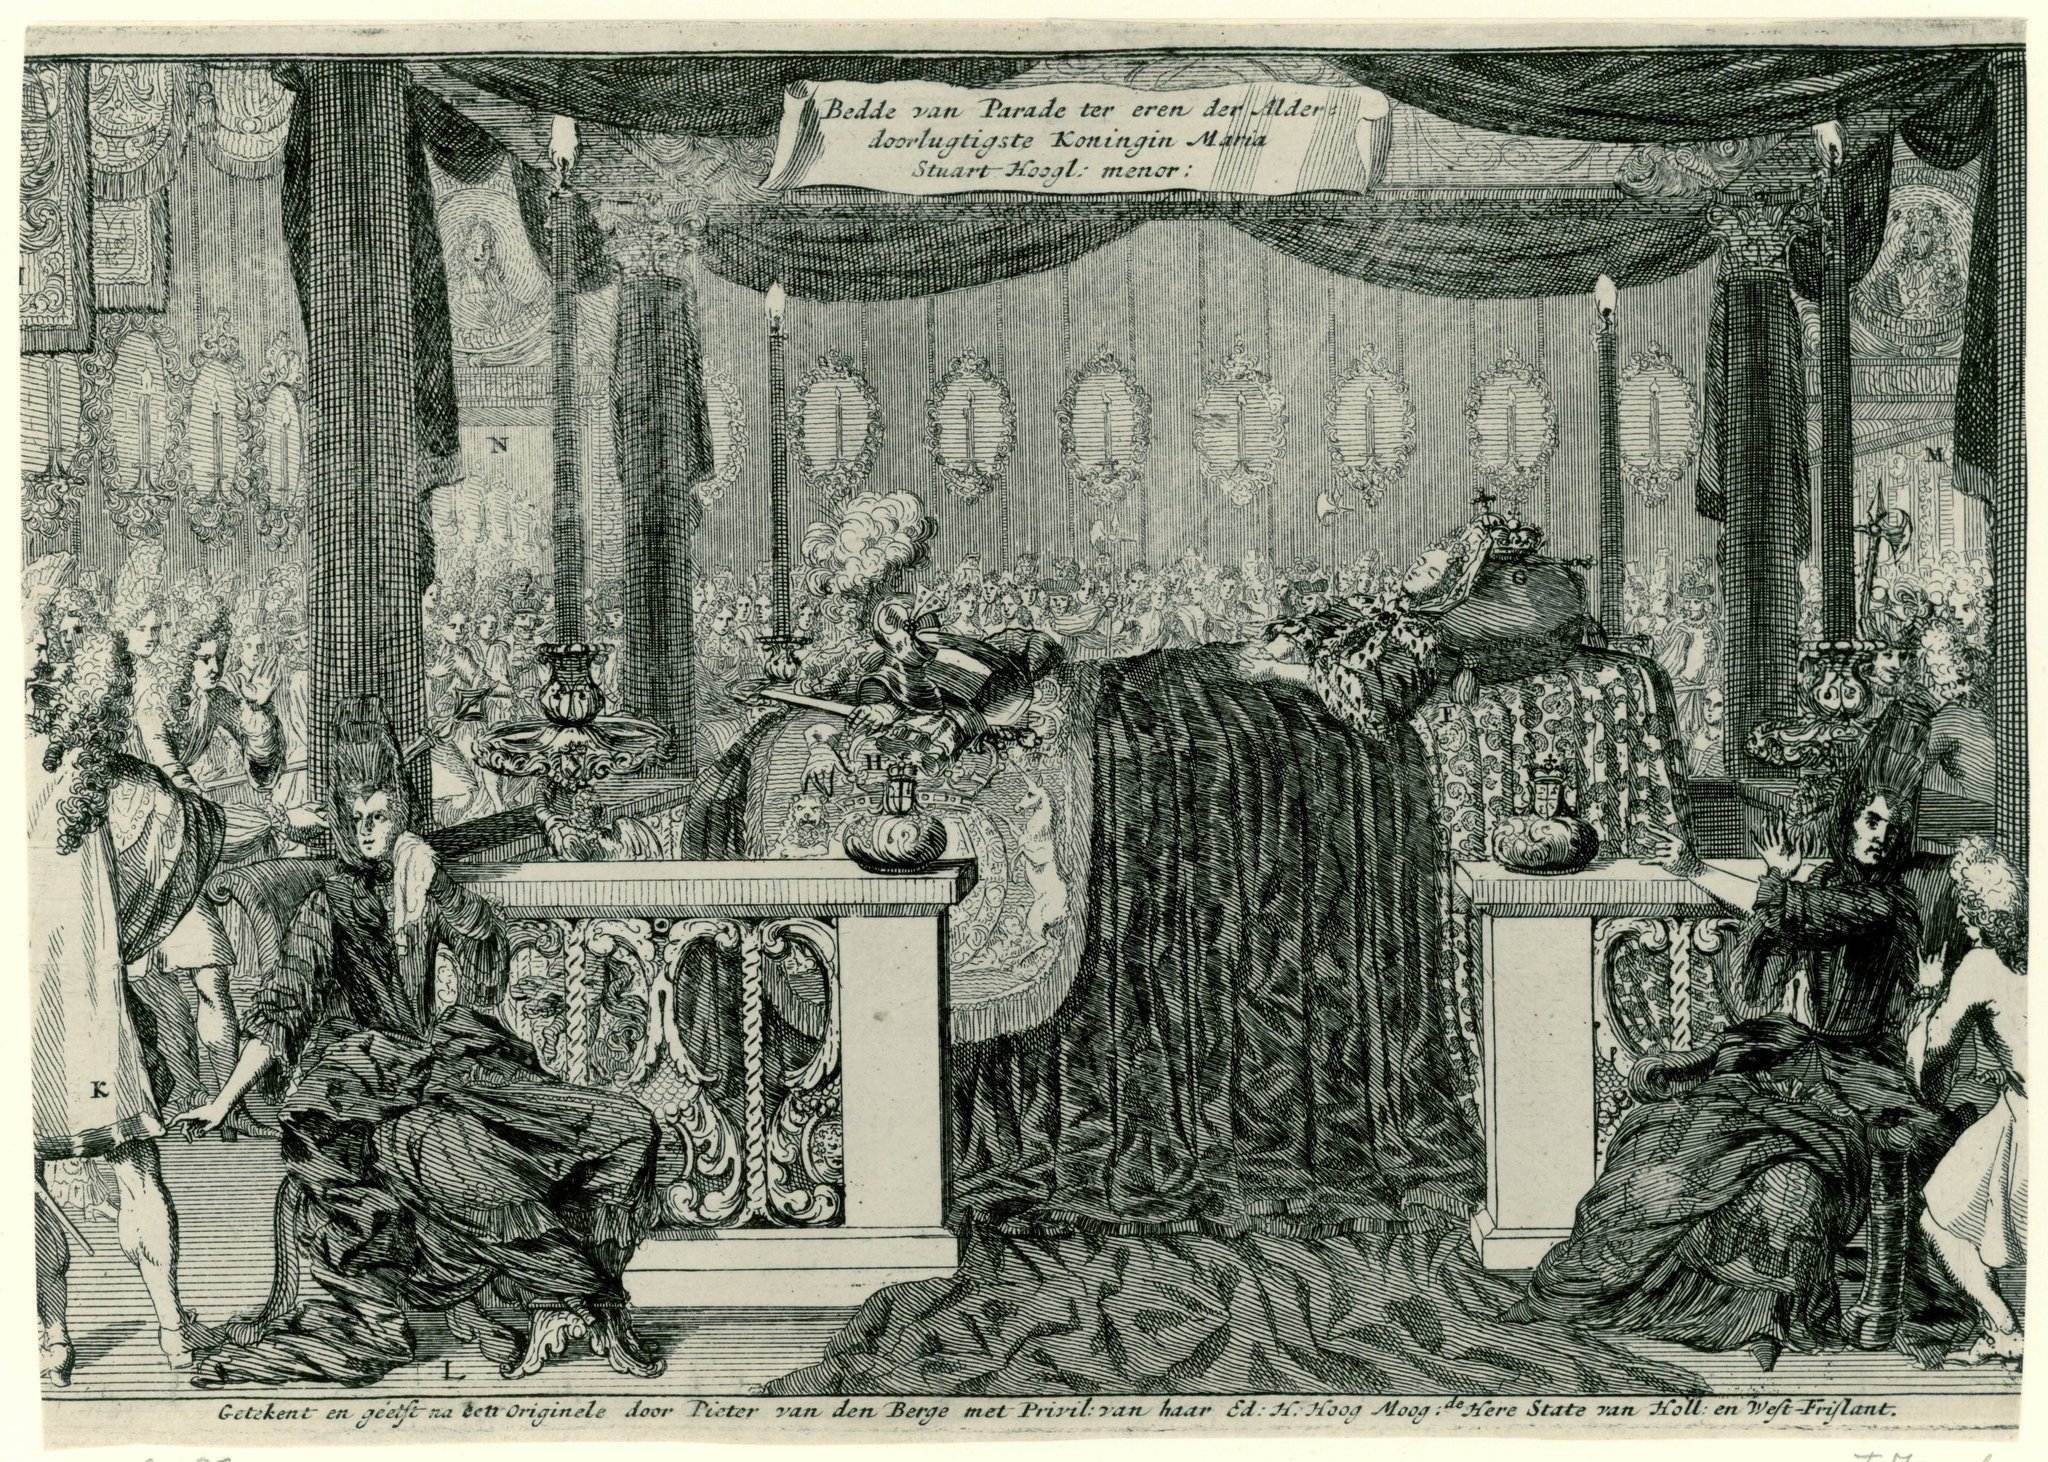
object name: print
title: Bed van parade van de overleden koningin Maria II Stuart, 1695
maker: pieter van den berge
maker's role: draughtsman, print maker, printer, publisher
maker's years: 1659-1737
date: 1695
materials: paper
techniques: etching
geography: amsterdam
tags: london, maria ii stuart (koningin van engeland, schotland en ierland), lying in state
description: De op 7 januari overleden koningin opgebaard op het bed van parade in een kamer verlicht met kaarsen. Op de voorgrond twee treurende hofdames. De prent maakt onderdeel uit van een groep van drie prenten over de dood van Maria Stuart, geëtst en uitgegeven door Pieter van den Berge in 1695.